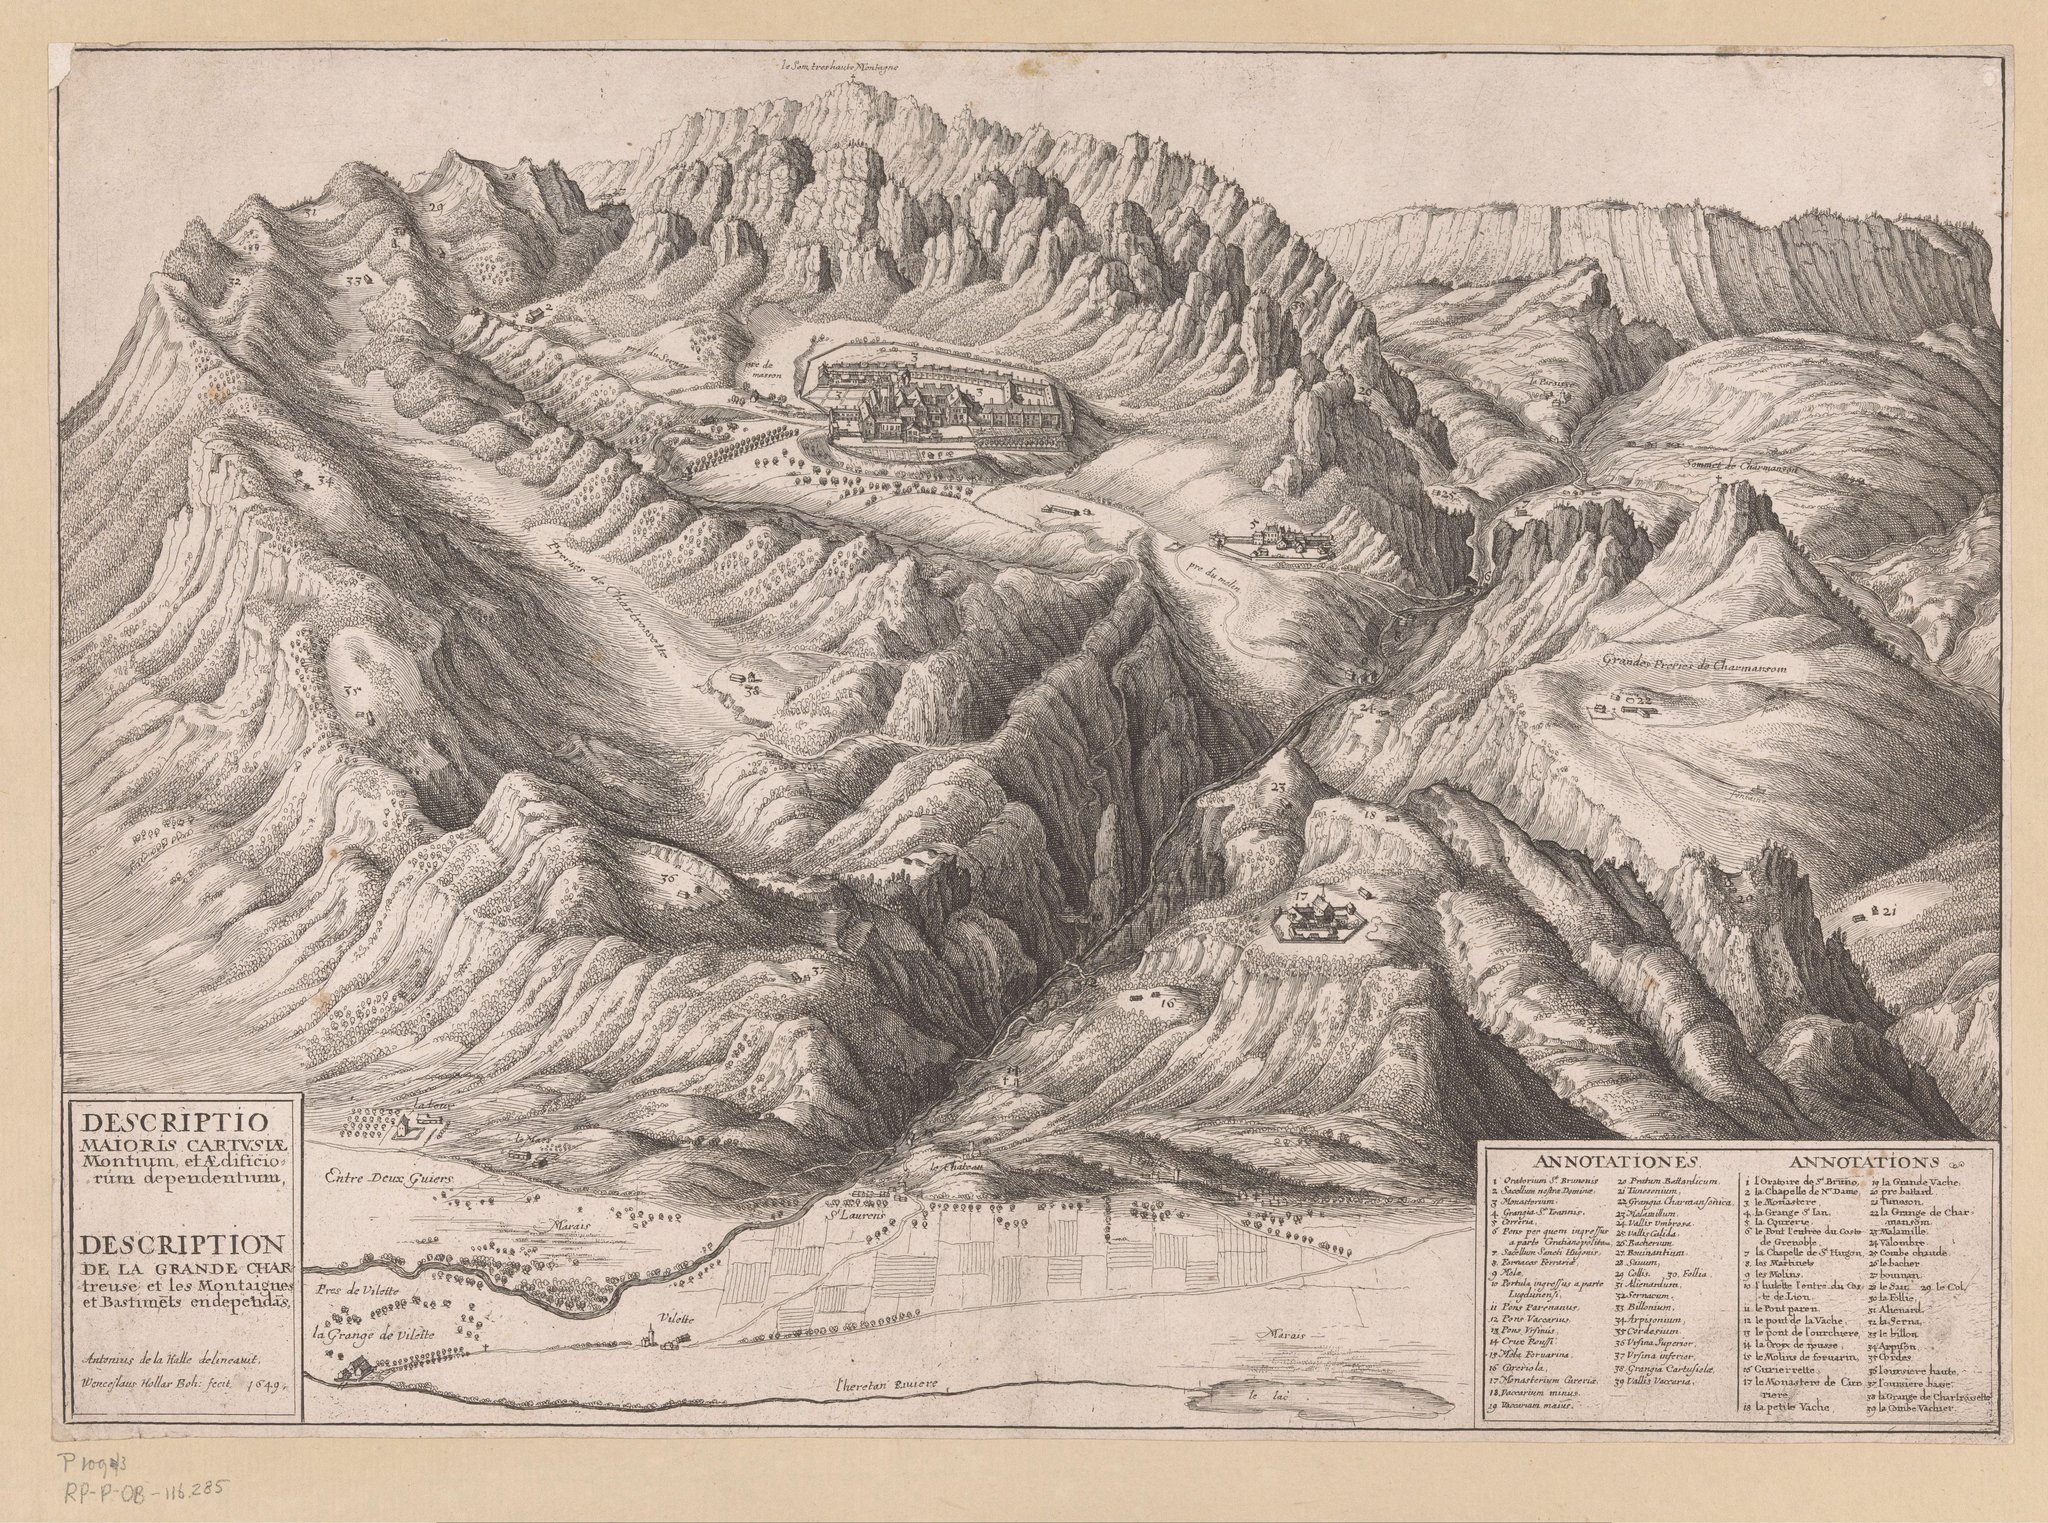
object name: print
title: Descriptio Maioris Cartusiae Montium et Aedificio rum dependentiun, (...)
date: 1649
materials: paper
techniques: etching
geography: antwerp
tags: maps of separate countries or regions, cloisters ~ monastery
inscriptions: collector's mark: Lugt 240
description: Gezicht op het klooster Grande Chartreuse (Kartuizer orde), dat in het Franse Alpengebied Chartreuse ligt en op twintig kilometer afstand van Grenoble. Rechtsonder een kader met de legenda met tekst in het Latijn en Frans.